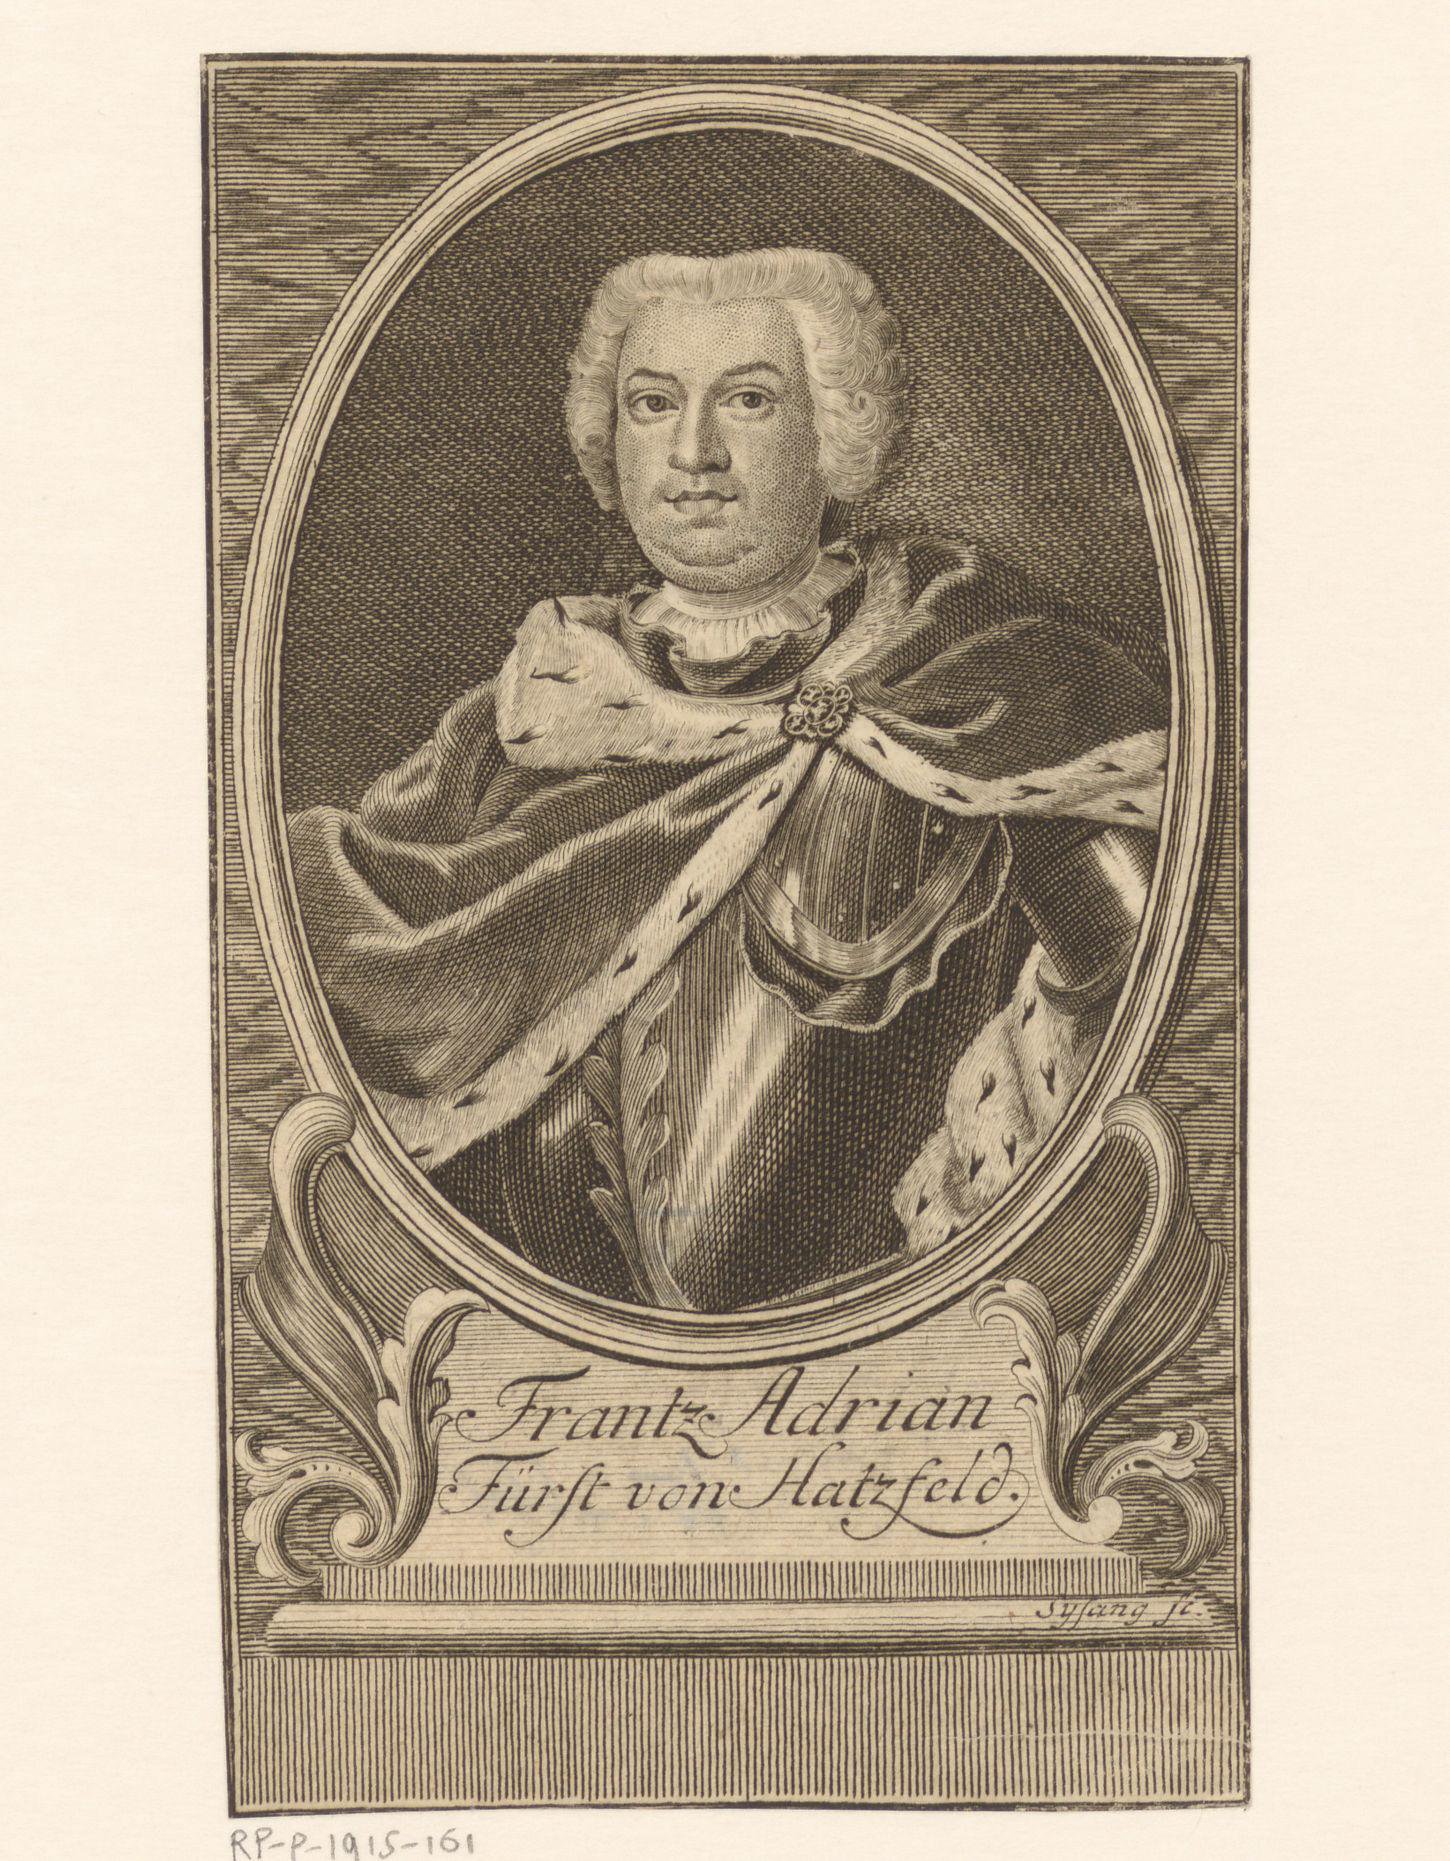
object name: print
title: Portret van Franz Philipp Adrian, Graf von Hatzfeld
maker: johann christoph sysang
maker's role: print maker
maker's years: 1703-1757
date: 1741-1757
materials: paper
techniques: engraving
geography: germany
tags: armour, historical persons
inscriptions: collector's mark: Lugt 2228